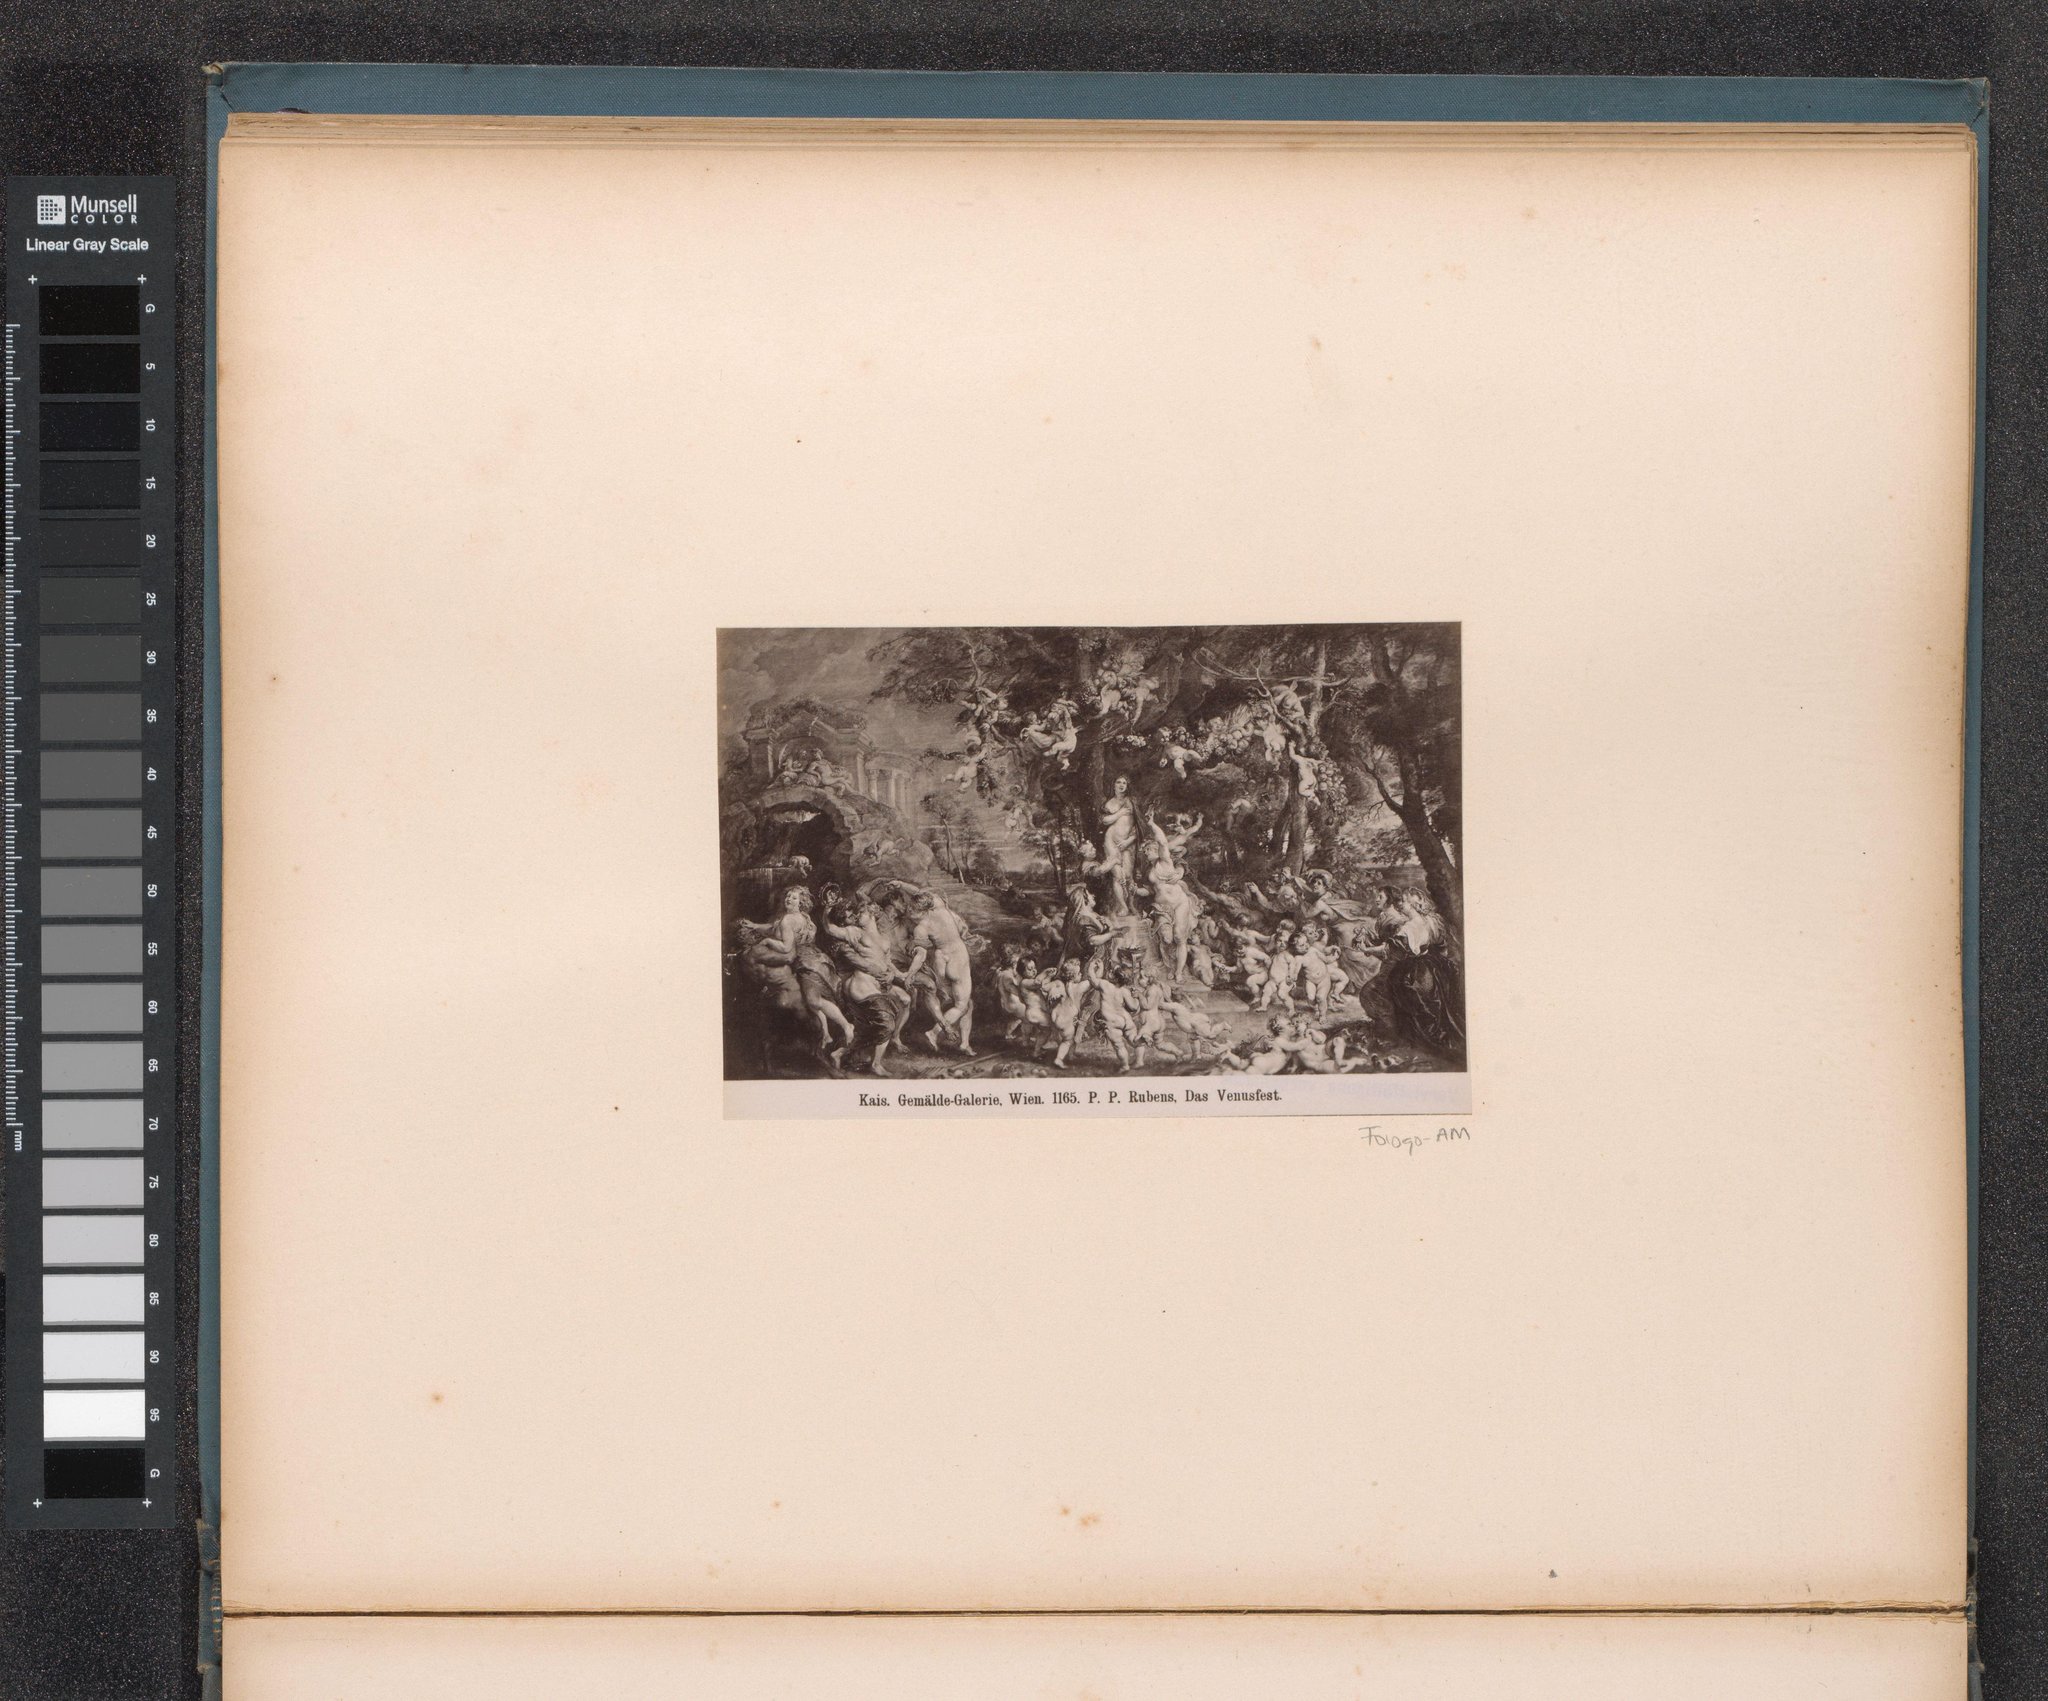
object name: photograph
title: Kais. Gemälde-Galerie. Wien. P. P. Rubens, Das Venusfest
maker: Anonymous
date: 1870-1900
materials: paper, photographic support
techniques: albumen print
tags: (story of) venus (aphrodite), cupids: 'amores', 'amoretti', 'putti'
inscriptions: check stamp: ‘[...]’, negative number: ‘1165’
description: Onderdeel van Reisalbum met foto's van bezienswaardigheden in Duitsland en Oostenrijk en van kunstwerken.